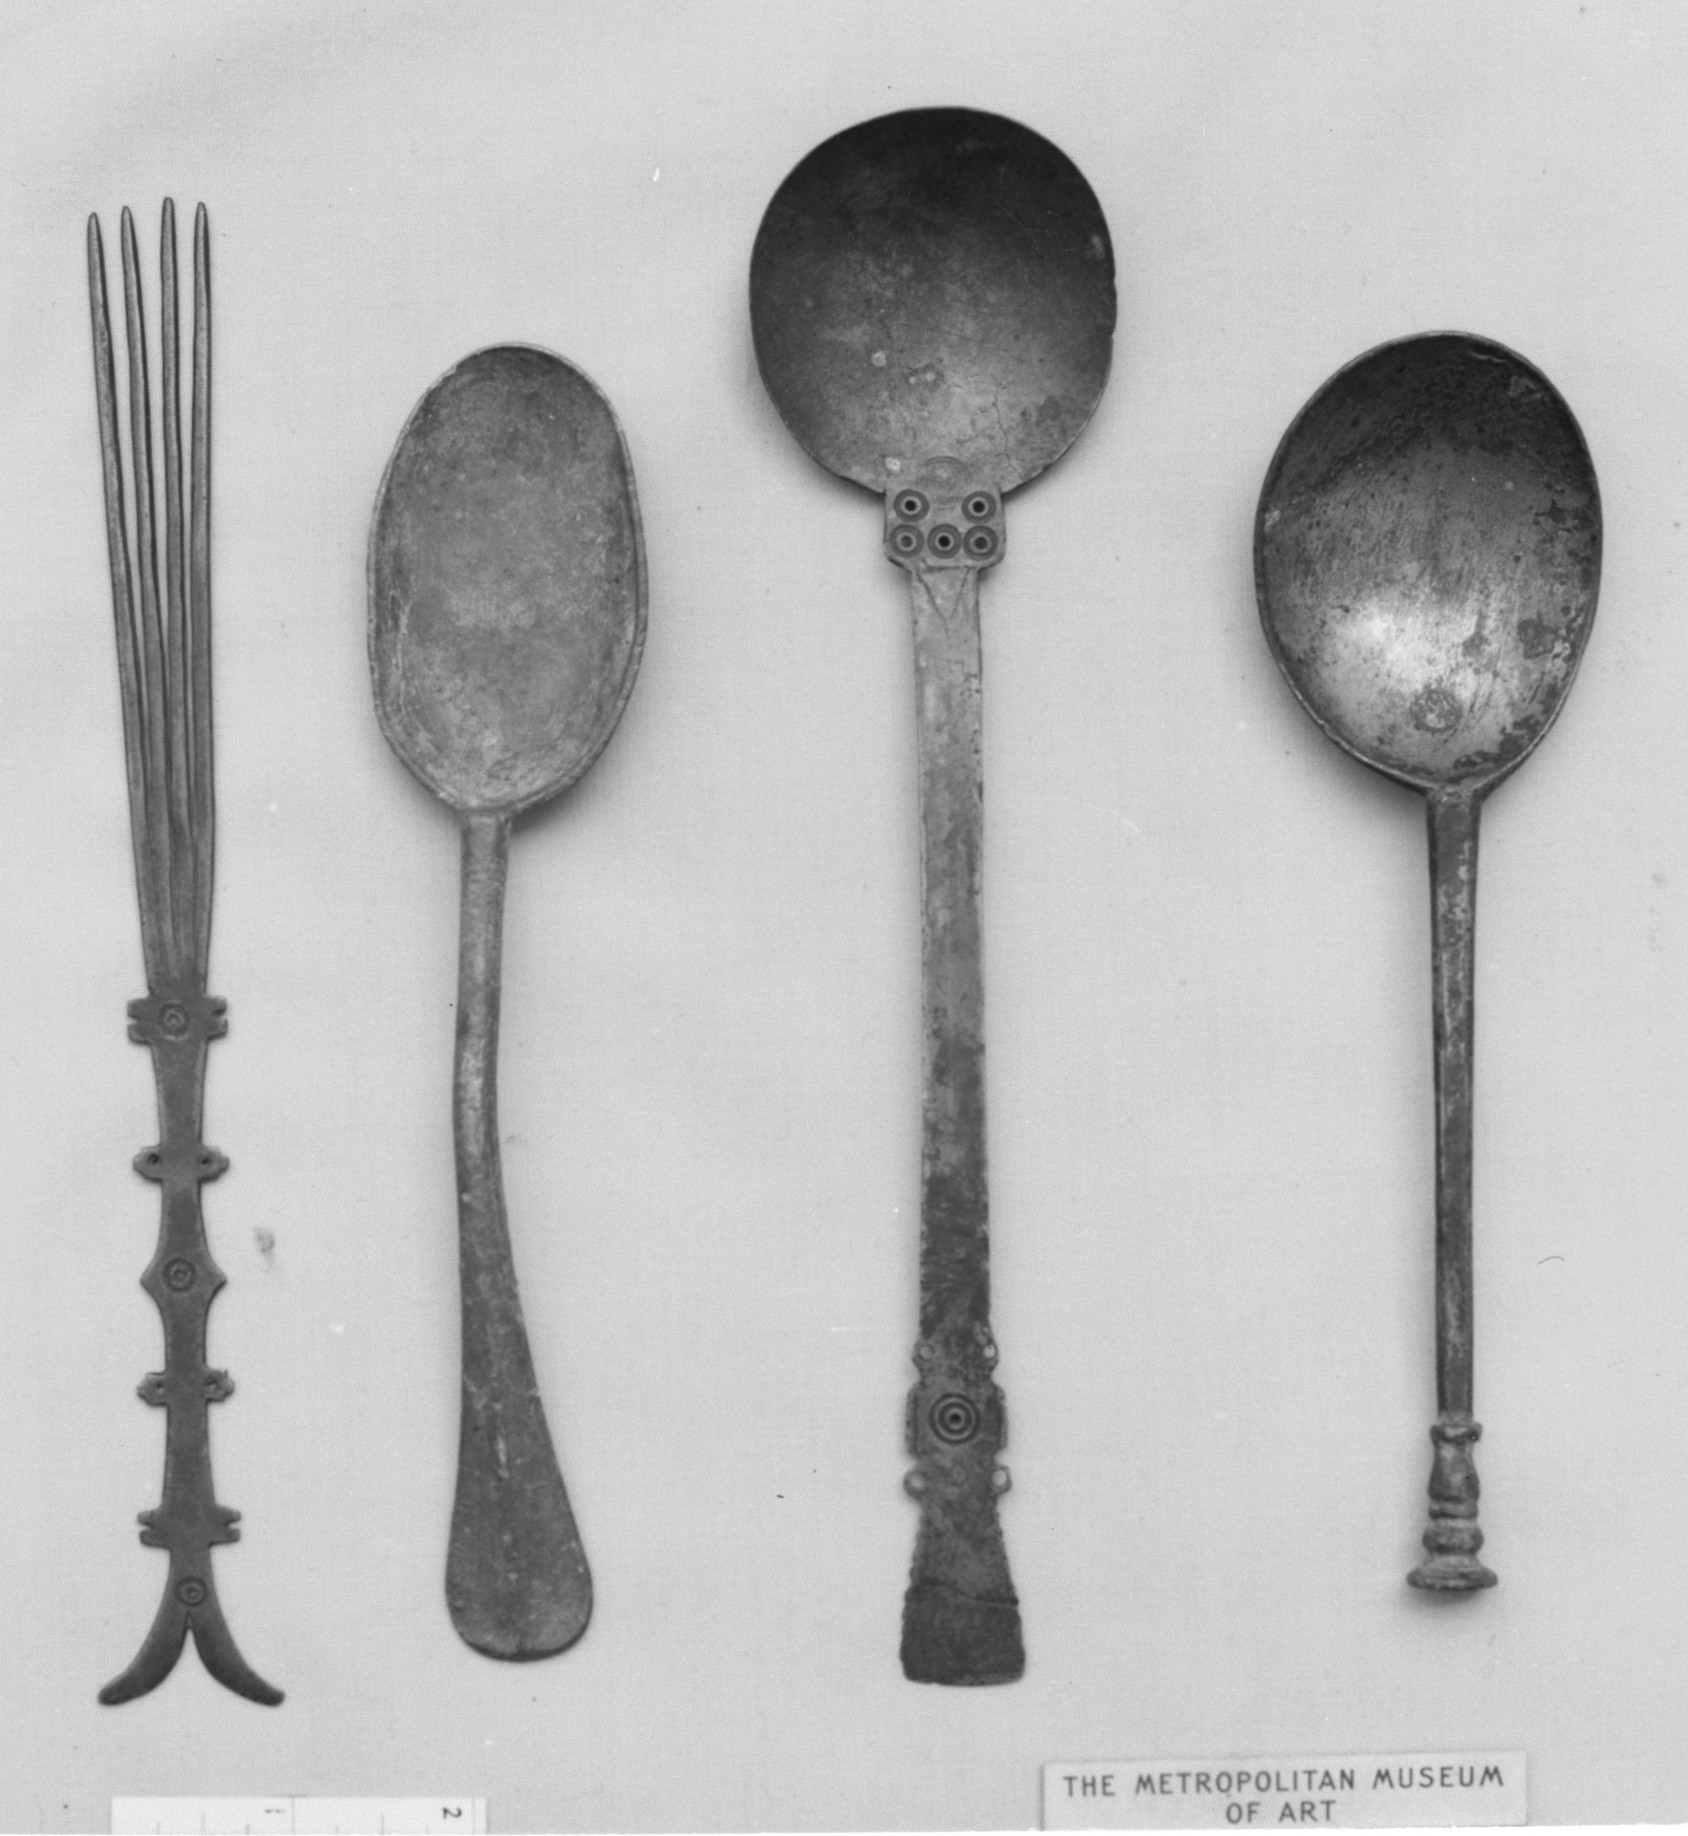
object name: spoon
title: Seal-top spoon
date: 1567-1633